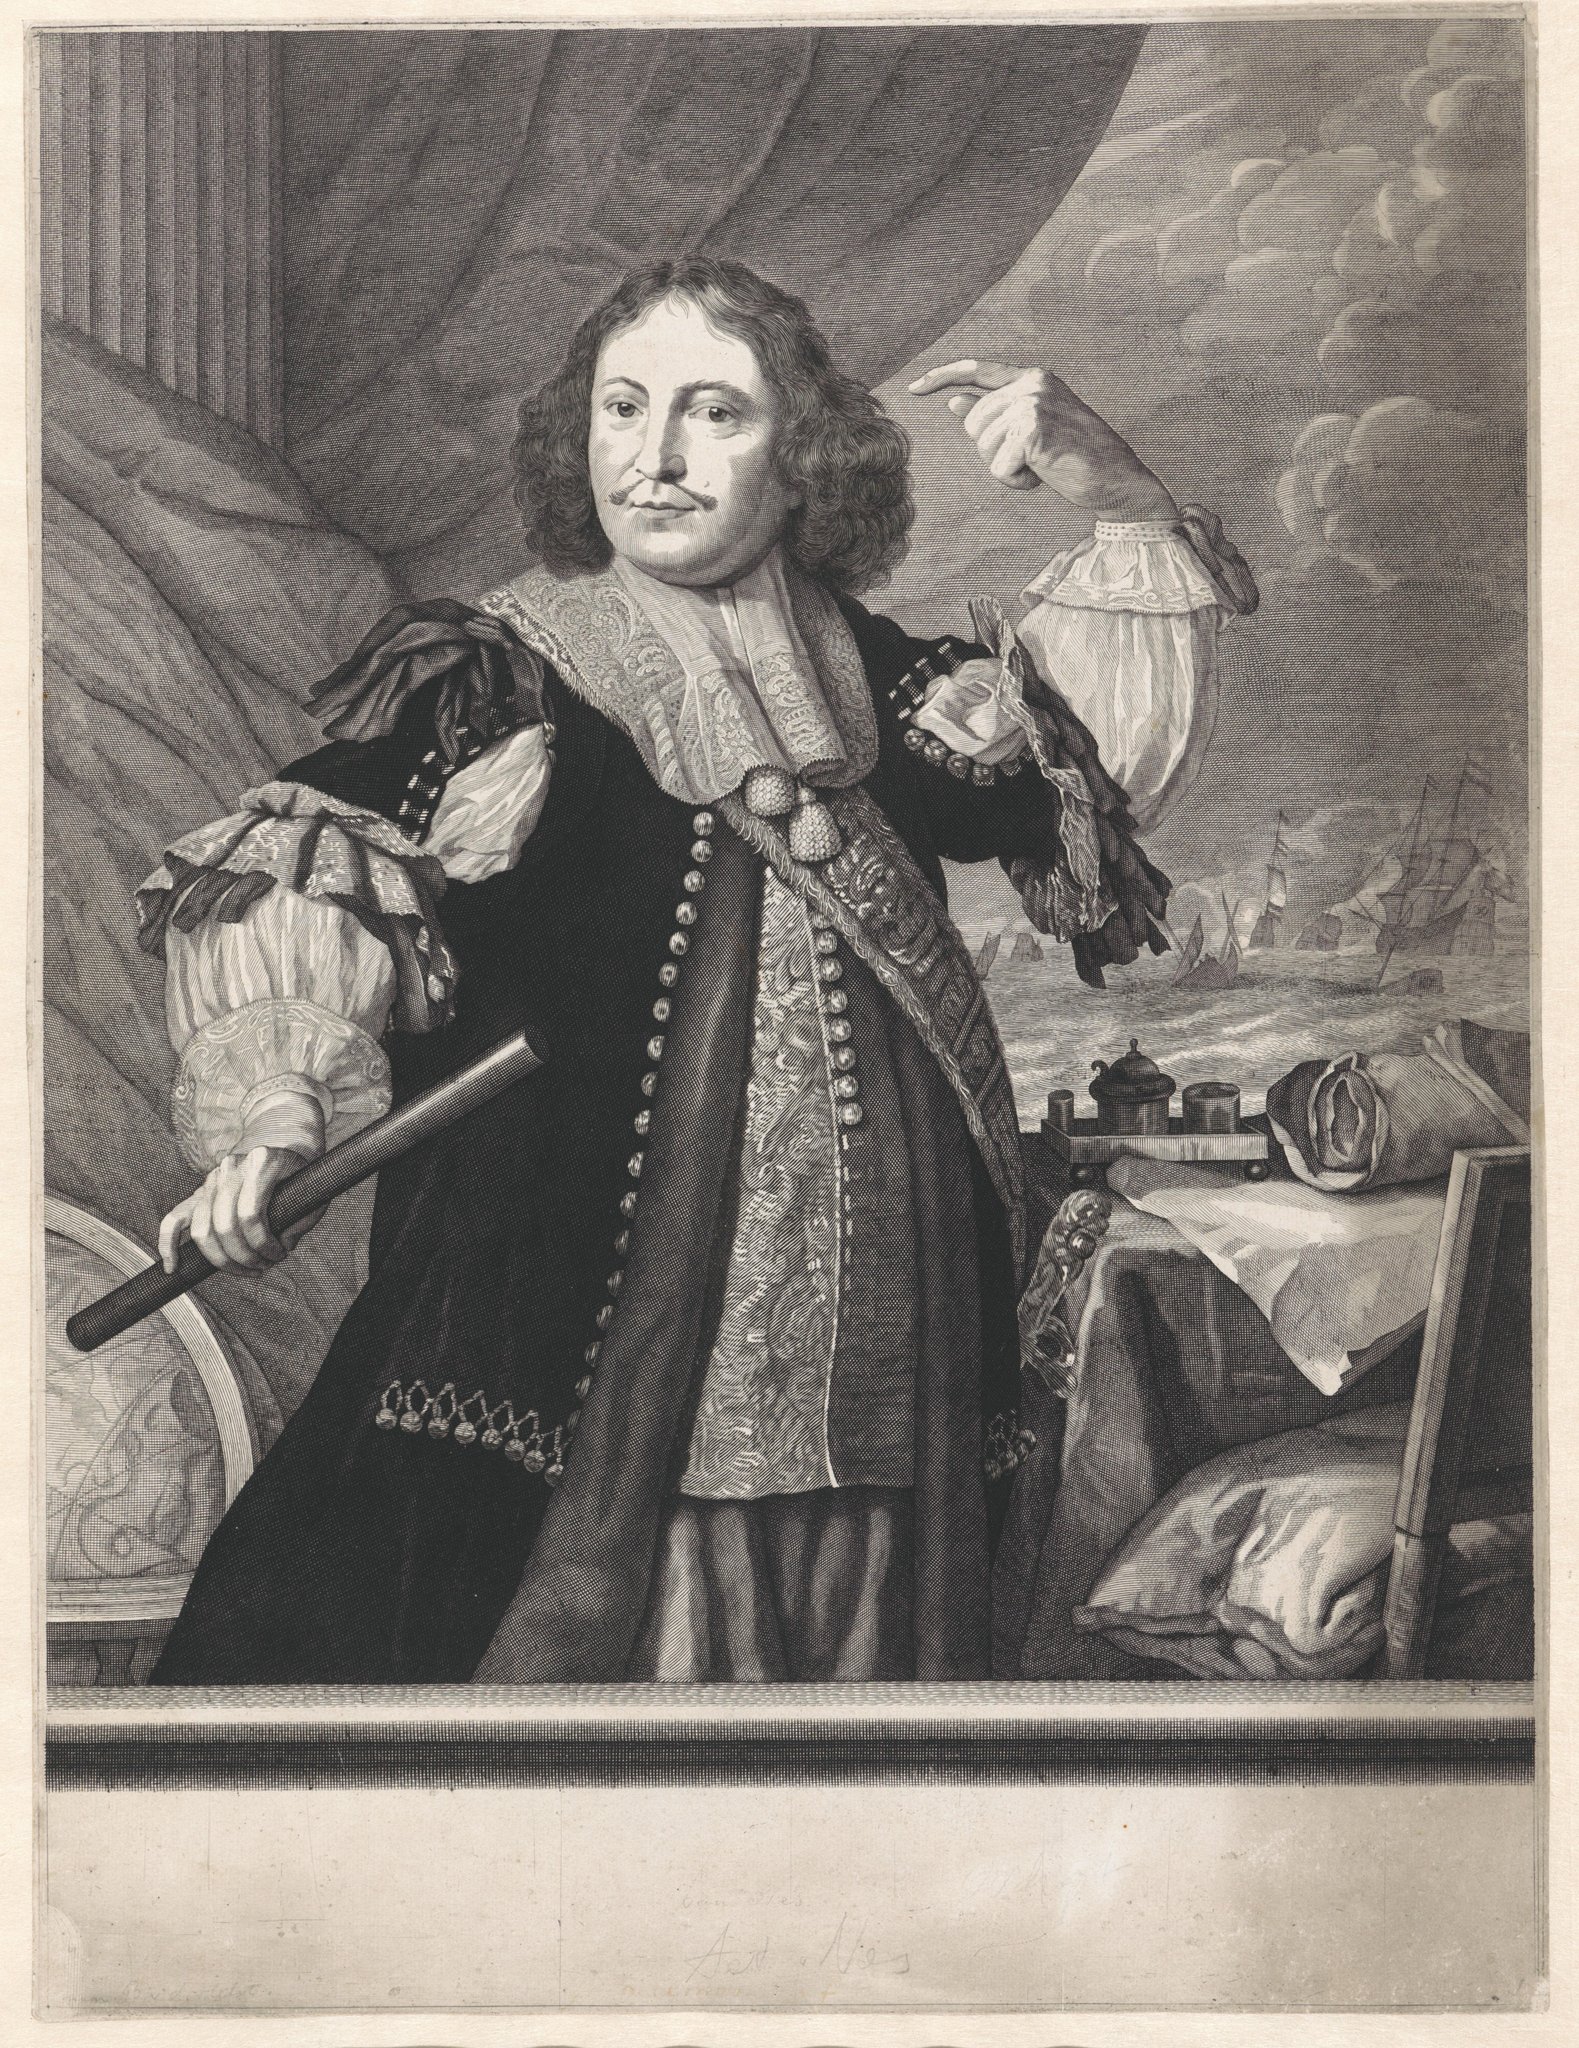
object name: print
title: Portret van Aert Jansz. van Nes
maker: lambert visscher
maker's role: draughtsman, print maker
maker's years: 1640-1679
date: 1668-1690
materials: paper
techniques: engraving, etching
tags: rotterdam, maps, atlases, battle (+ naval force), globe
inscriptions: collector's mark: Lugt 2228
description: Aert van Nes, luitenant-admiraal, staand met commandostok in de rechterhand en opgeheven linkerarm. Rechts een tafel met een inktstel en zeekaarten en links een globe. Op de achtergrond een zeegezicht met een zeeslag.